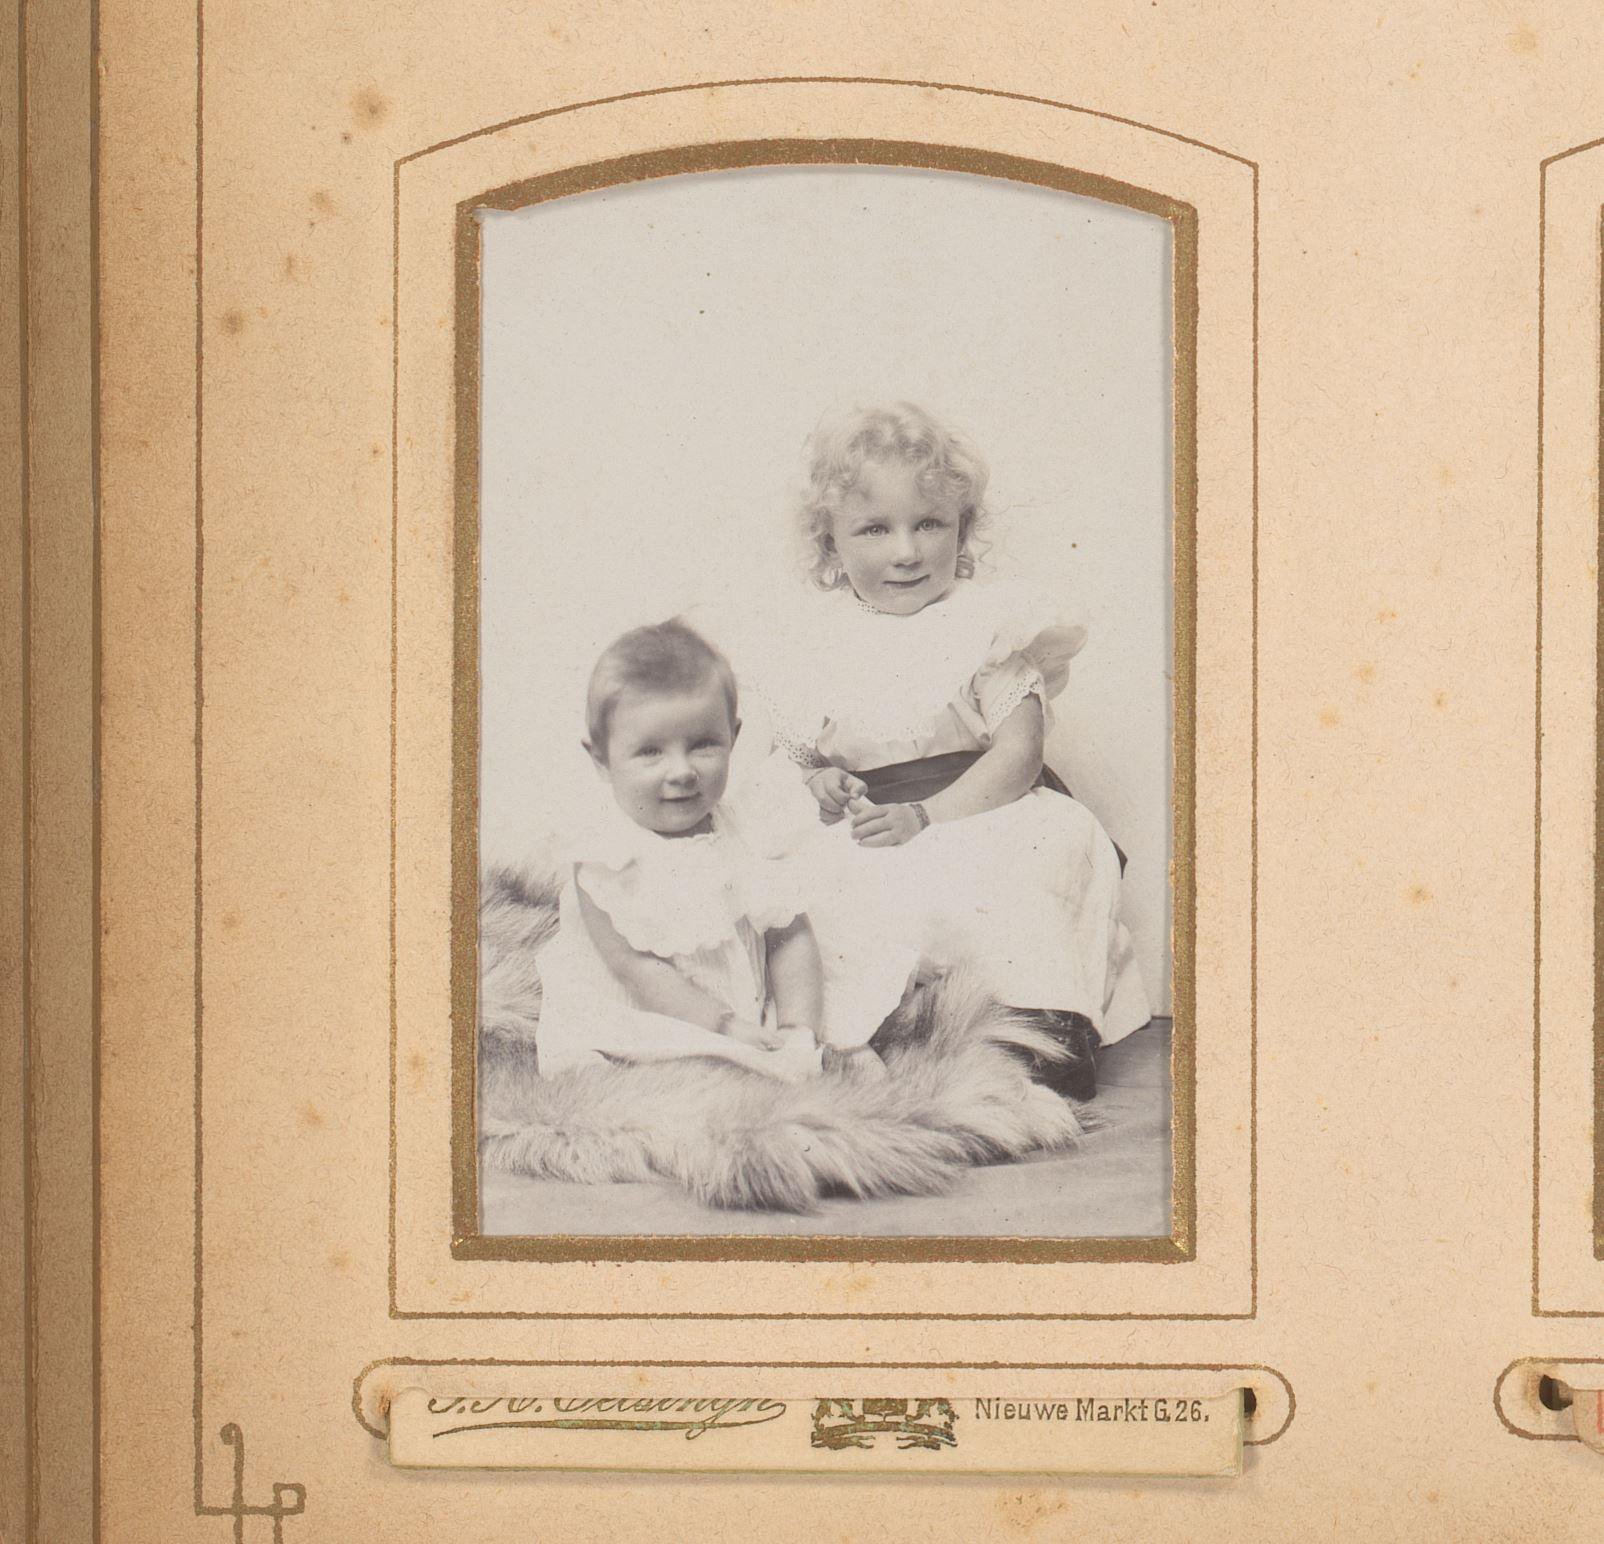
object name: photograph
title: Portret van een meisje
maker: jan anthonie eelsingh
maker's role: fotograaf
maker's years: 1866-1949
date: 1898-1901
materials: cardboard, photographic support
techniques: collodion silver print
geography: zwolle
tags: historical persons - bb - woman, girl (child between toddler and youth)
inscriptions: inscription: ‘J.A. Eelsingh/ Zwolle/ Nieuwe Markt G.26’